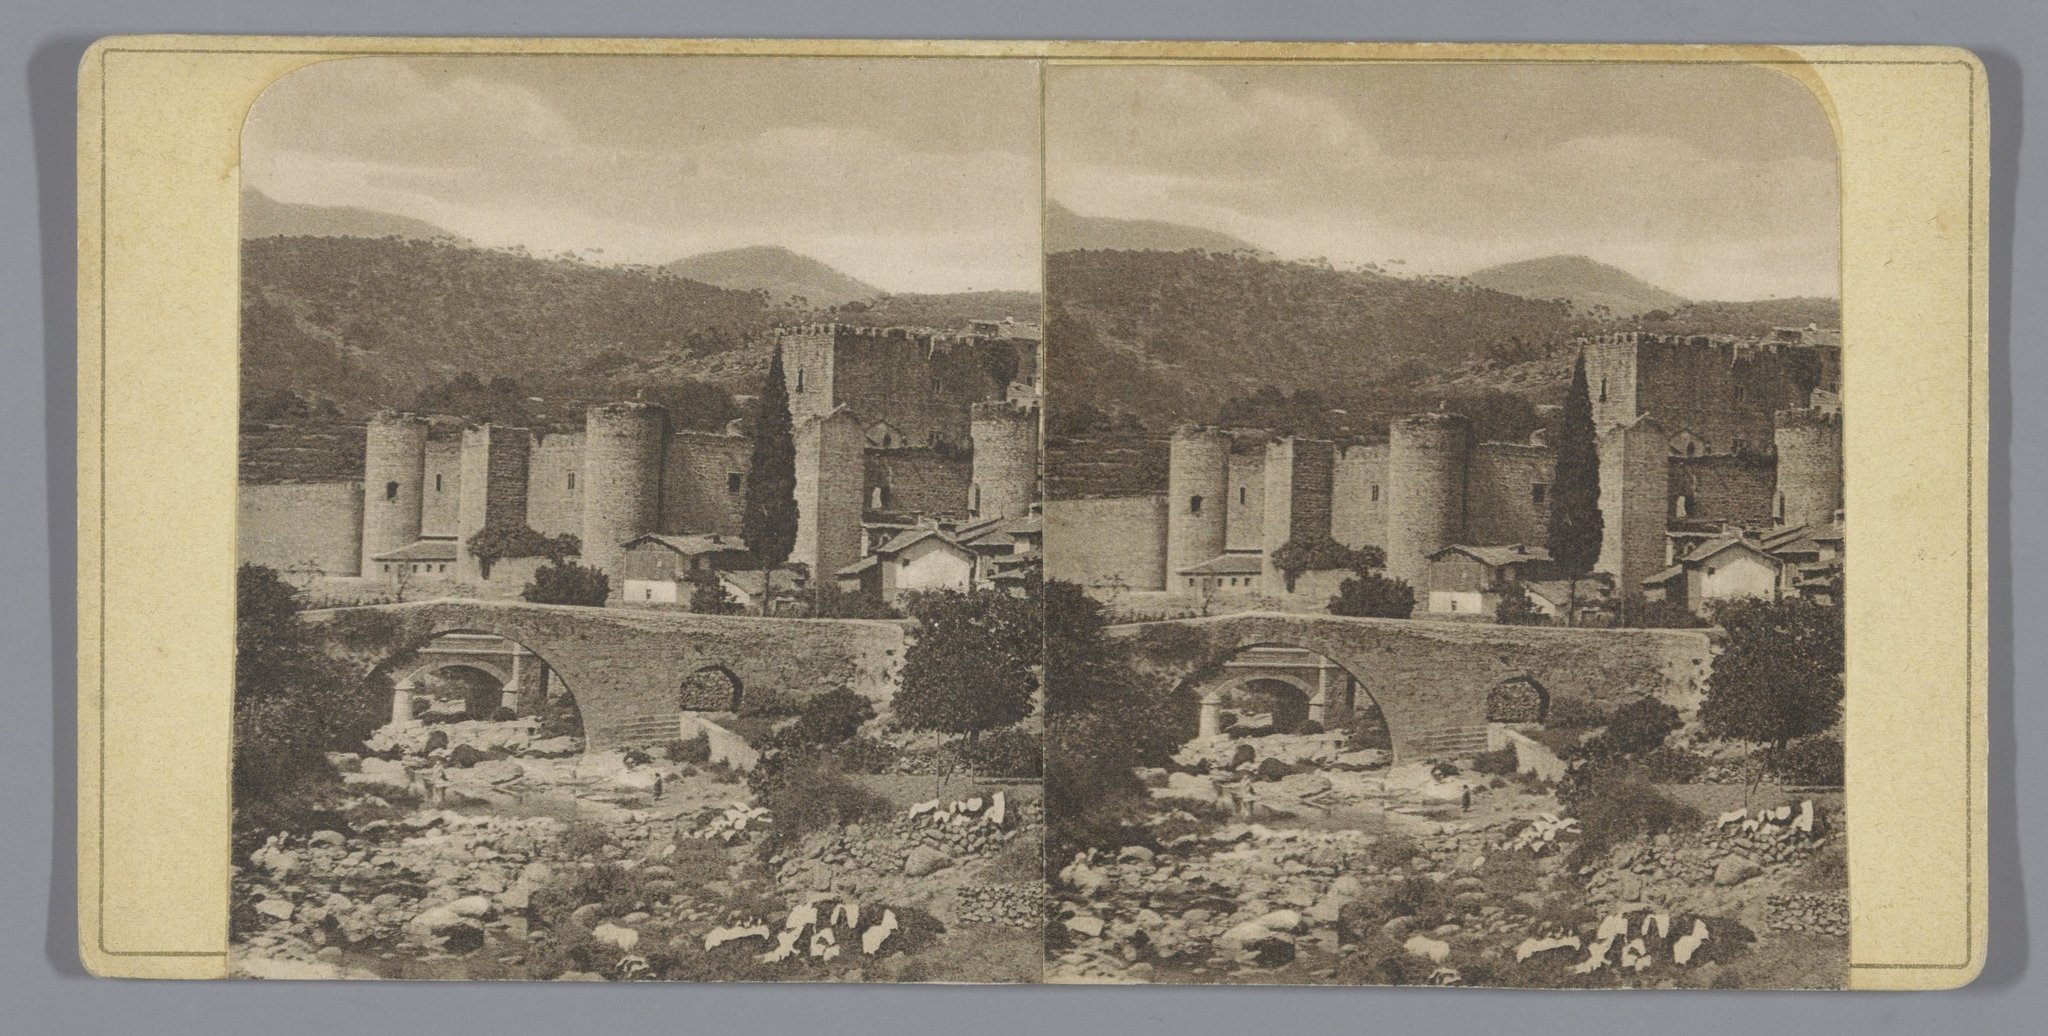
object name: stereograph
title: Gezicht op het kasteel van Arenas de Pedro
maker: Anonymous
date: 1890-1920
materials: cardboard, paper, ink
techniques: photograph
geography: avila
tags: city-view in general; 'veduta'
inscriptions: inscription: ‘Sierra de Gredos. Arenas de San Pedro. (avila) Vista del Castíllo y el rio Arenal.’